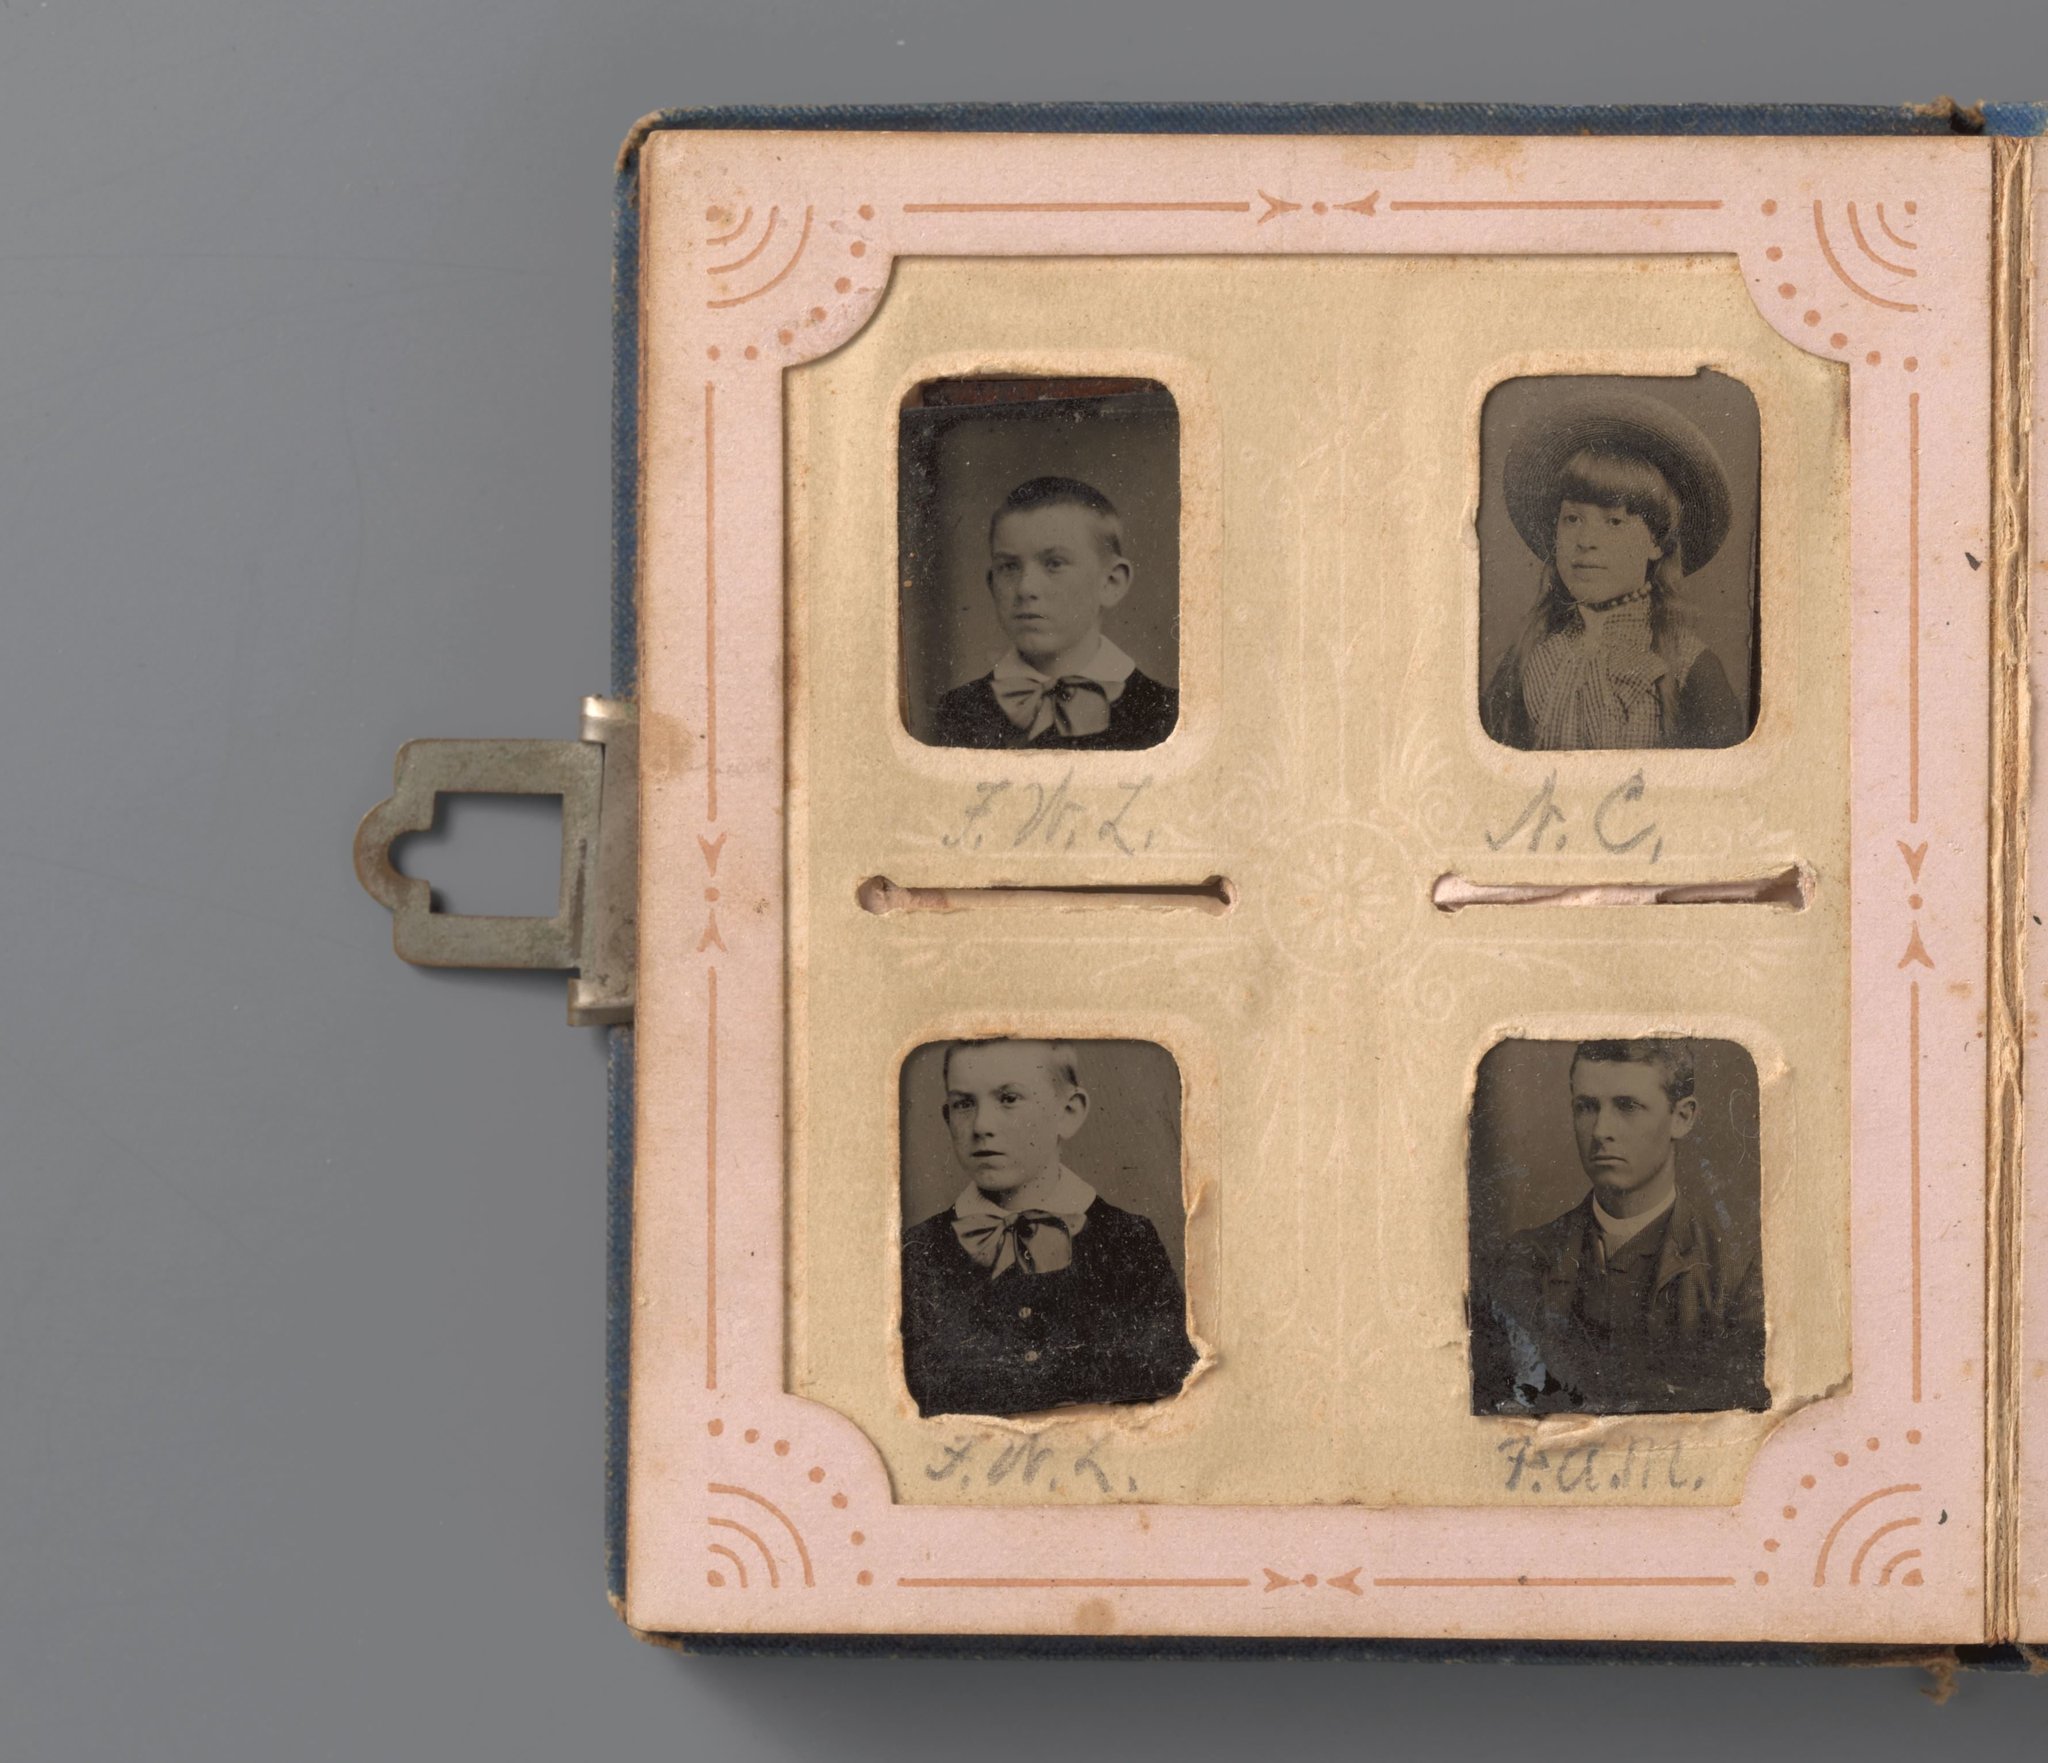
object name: photograph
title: Vier portretten van jonge mannen en een jonge vrouw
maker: Anonymous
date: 1855-1940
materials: cardboard, iron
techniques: ferrotyping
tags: adolescent, young woman, maiden, historical persons - bb - woman, historical persons, youth, adolescent, head-gear: hat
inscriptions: monogram: ‘F.W.L.’, monogram: ‘A.C.’, monogram, monogram: ‘P.A.M.’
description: Deze foto's maken deel uit van een album.